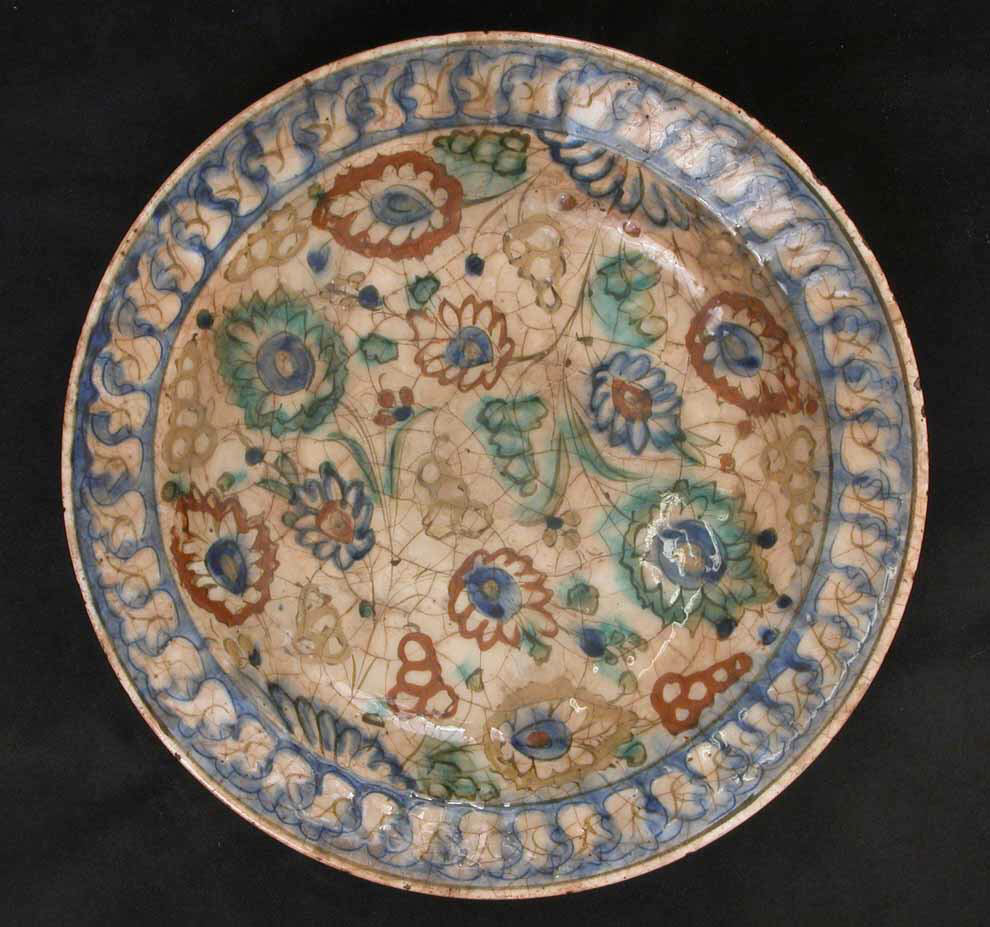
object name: dish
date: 1601-1700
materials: stonepaste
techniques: painting, underglaze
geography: iran